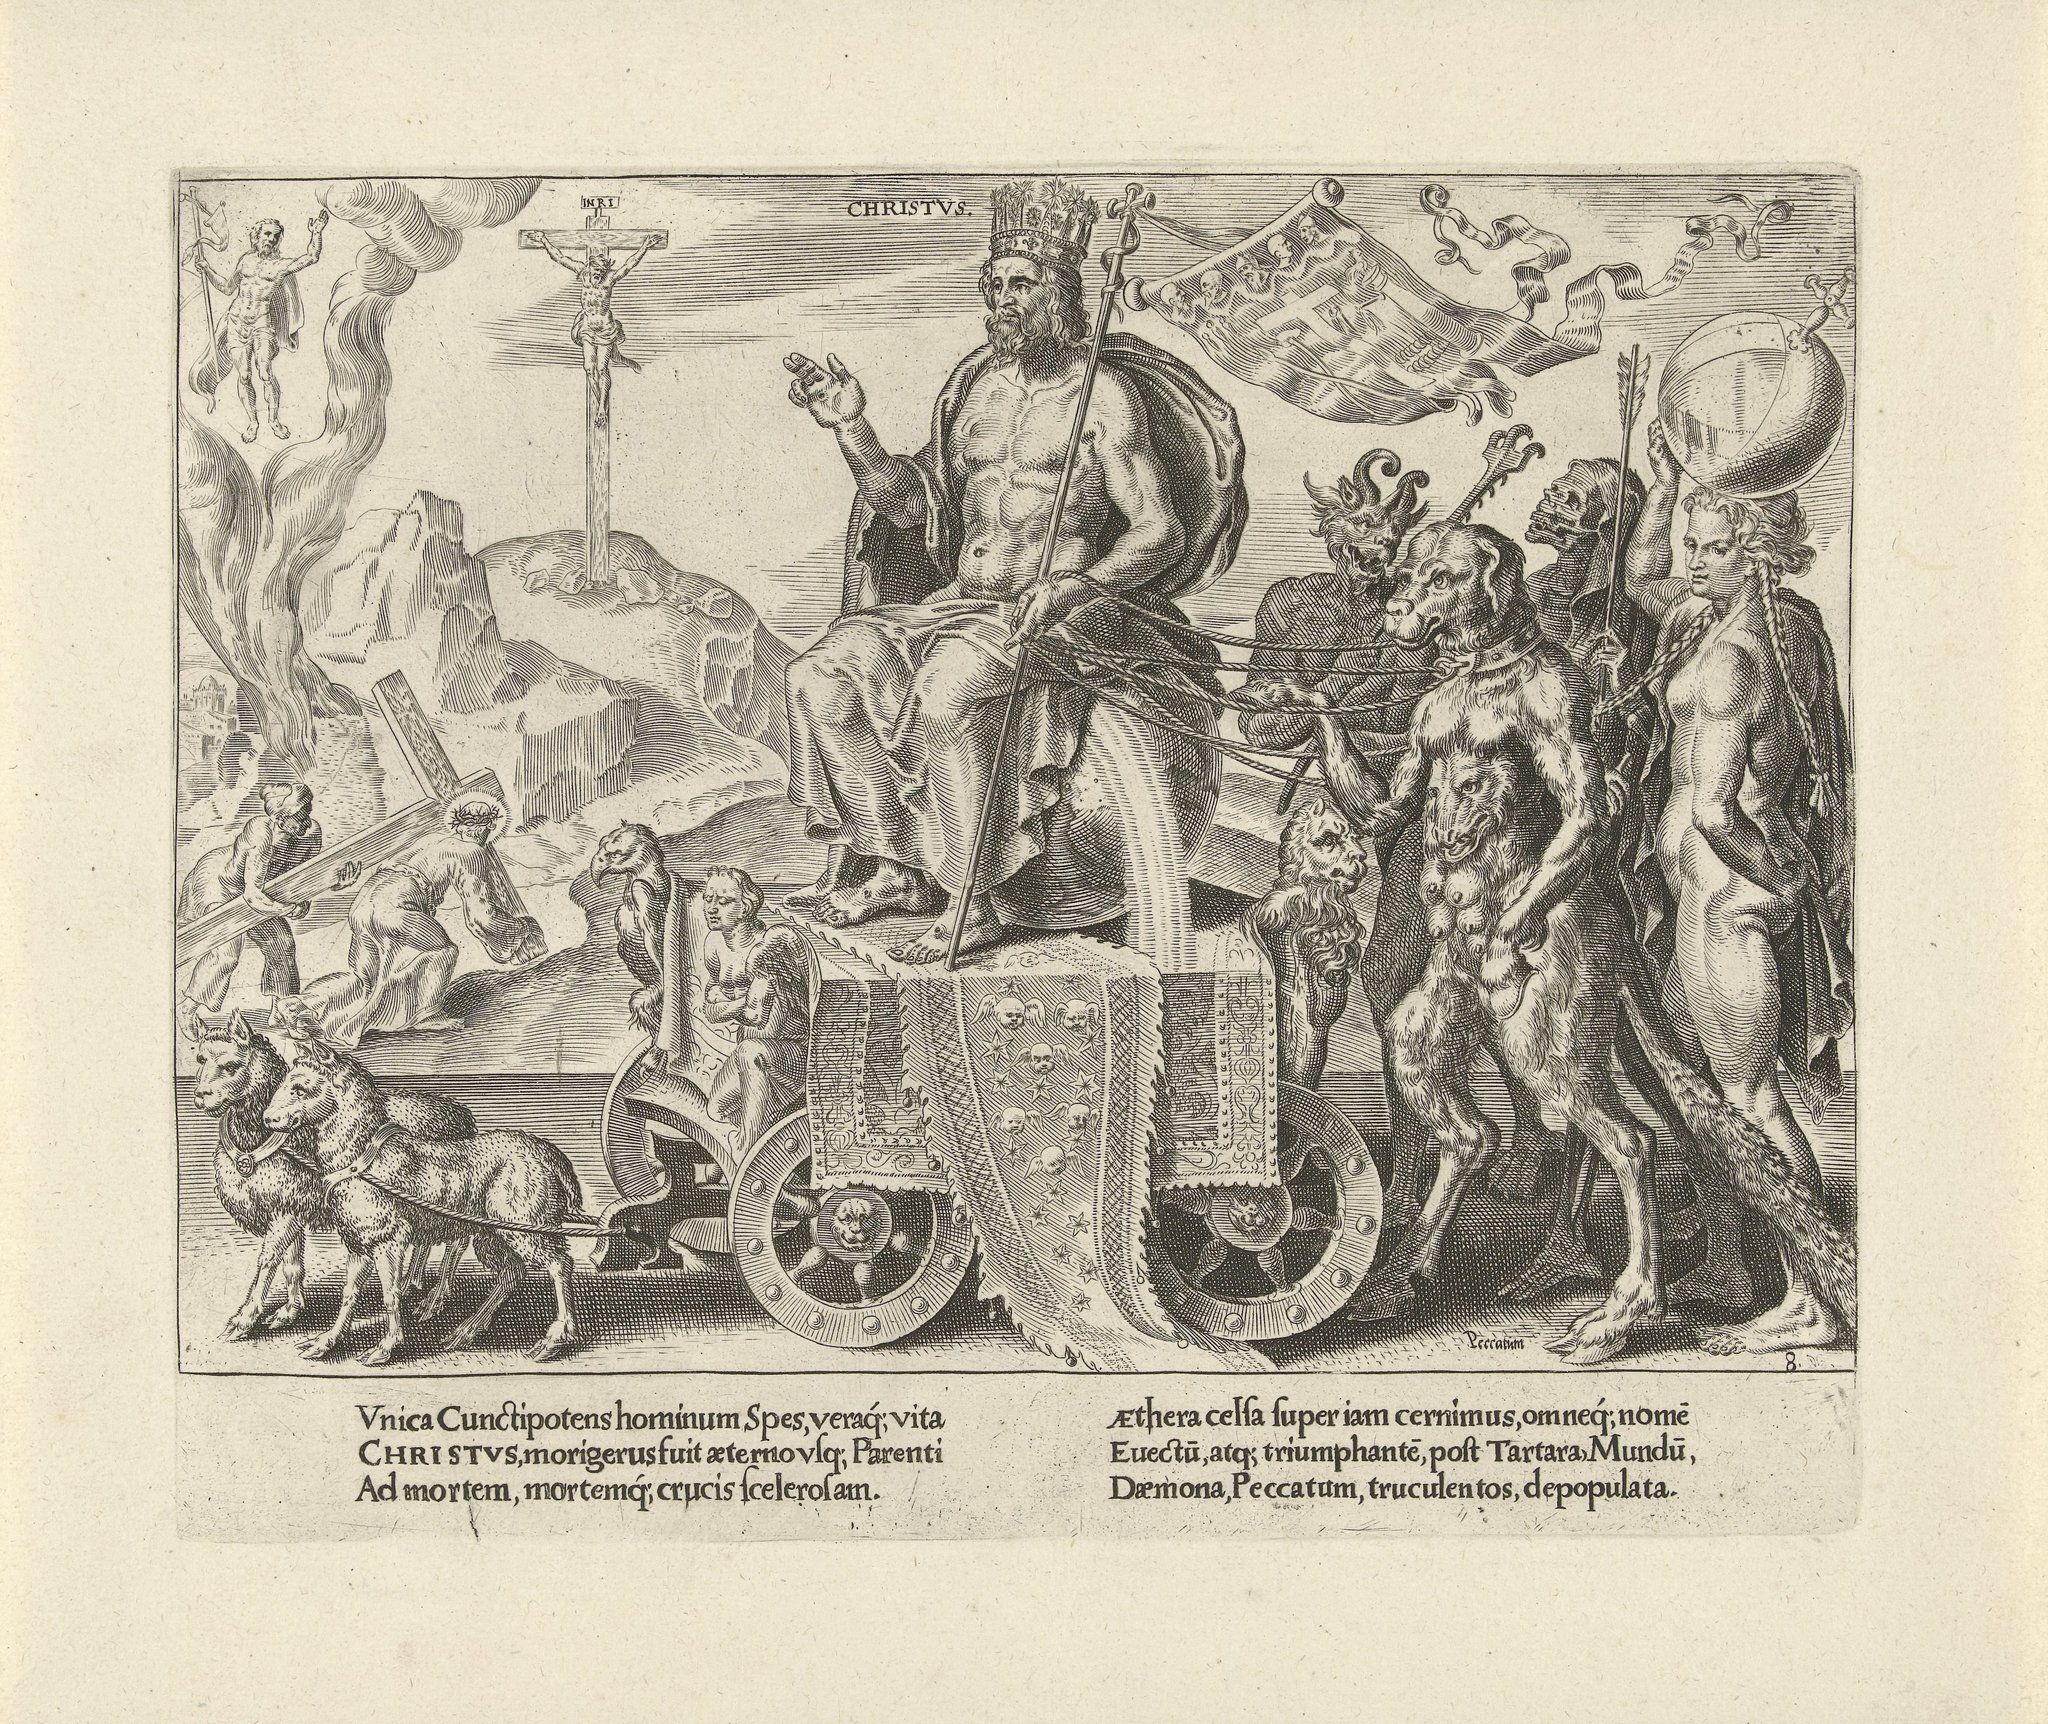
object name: print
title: Triomf van Christus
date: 1559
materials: paper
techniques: engraving, etching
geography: antwerp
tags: christ on the cross on golgotha (alone, without bystanders), resurrection of christ, death as man, the instruments of the passion and the five wounded limbs, devil(s) and demons: satan, vice, evil, sin; 'peccato' (ripa), triumphant christ, e.g. on triumphal chariot, 'mondo', 'machina del mondo' (ripa), carrying of the cross: christ bearing the cross, alone or with the help of others (e.g. simon the cyrenian)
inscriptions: collector's mark: Lugt 2228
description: Op de voorgrond Christus, rijdend op een triomfwagen getrokken door twee lammeren. Hij troont op de wereld. In zijn linkerhand een kruis met een vaandel. Op het vaandel de werktuigen van zijn passie. Achter de triomfwagen heeft Christus de Dood, Satan, Zonde (Peccatum) en Vrouwe Wereld geketend. Op de achtergrond worden Christus' kruisvaart, kruisdood en hemelvaart weergegeven. De prent heeft een Latijnse tekst van zes regels en maakt deel uit van een achtdelige serie over de triomf van de Lijdzaamheid.